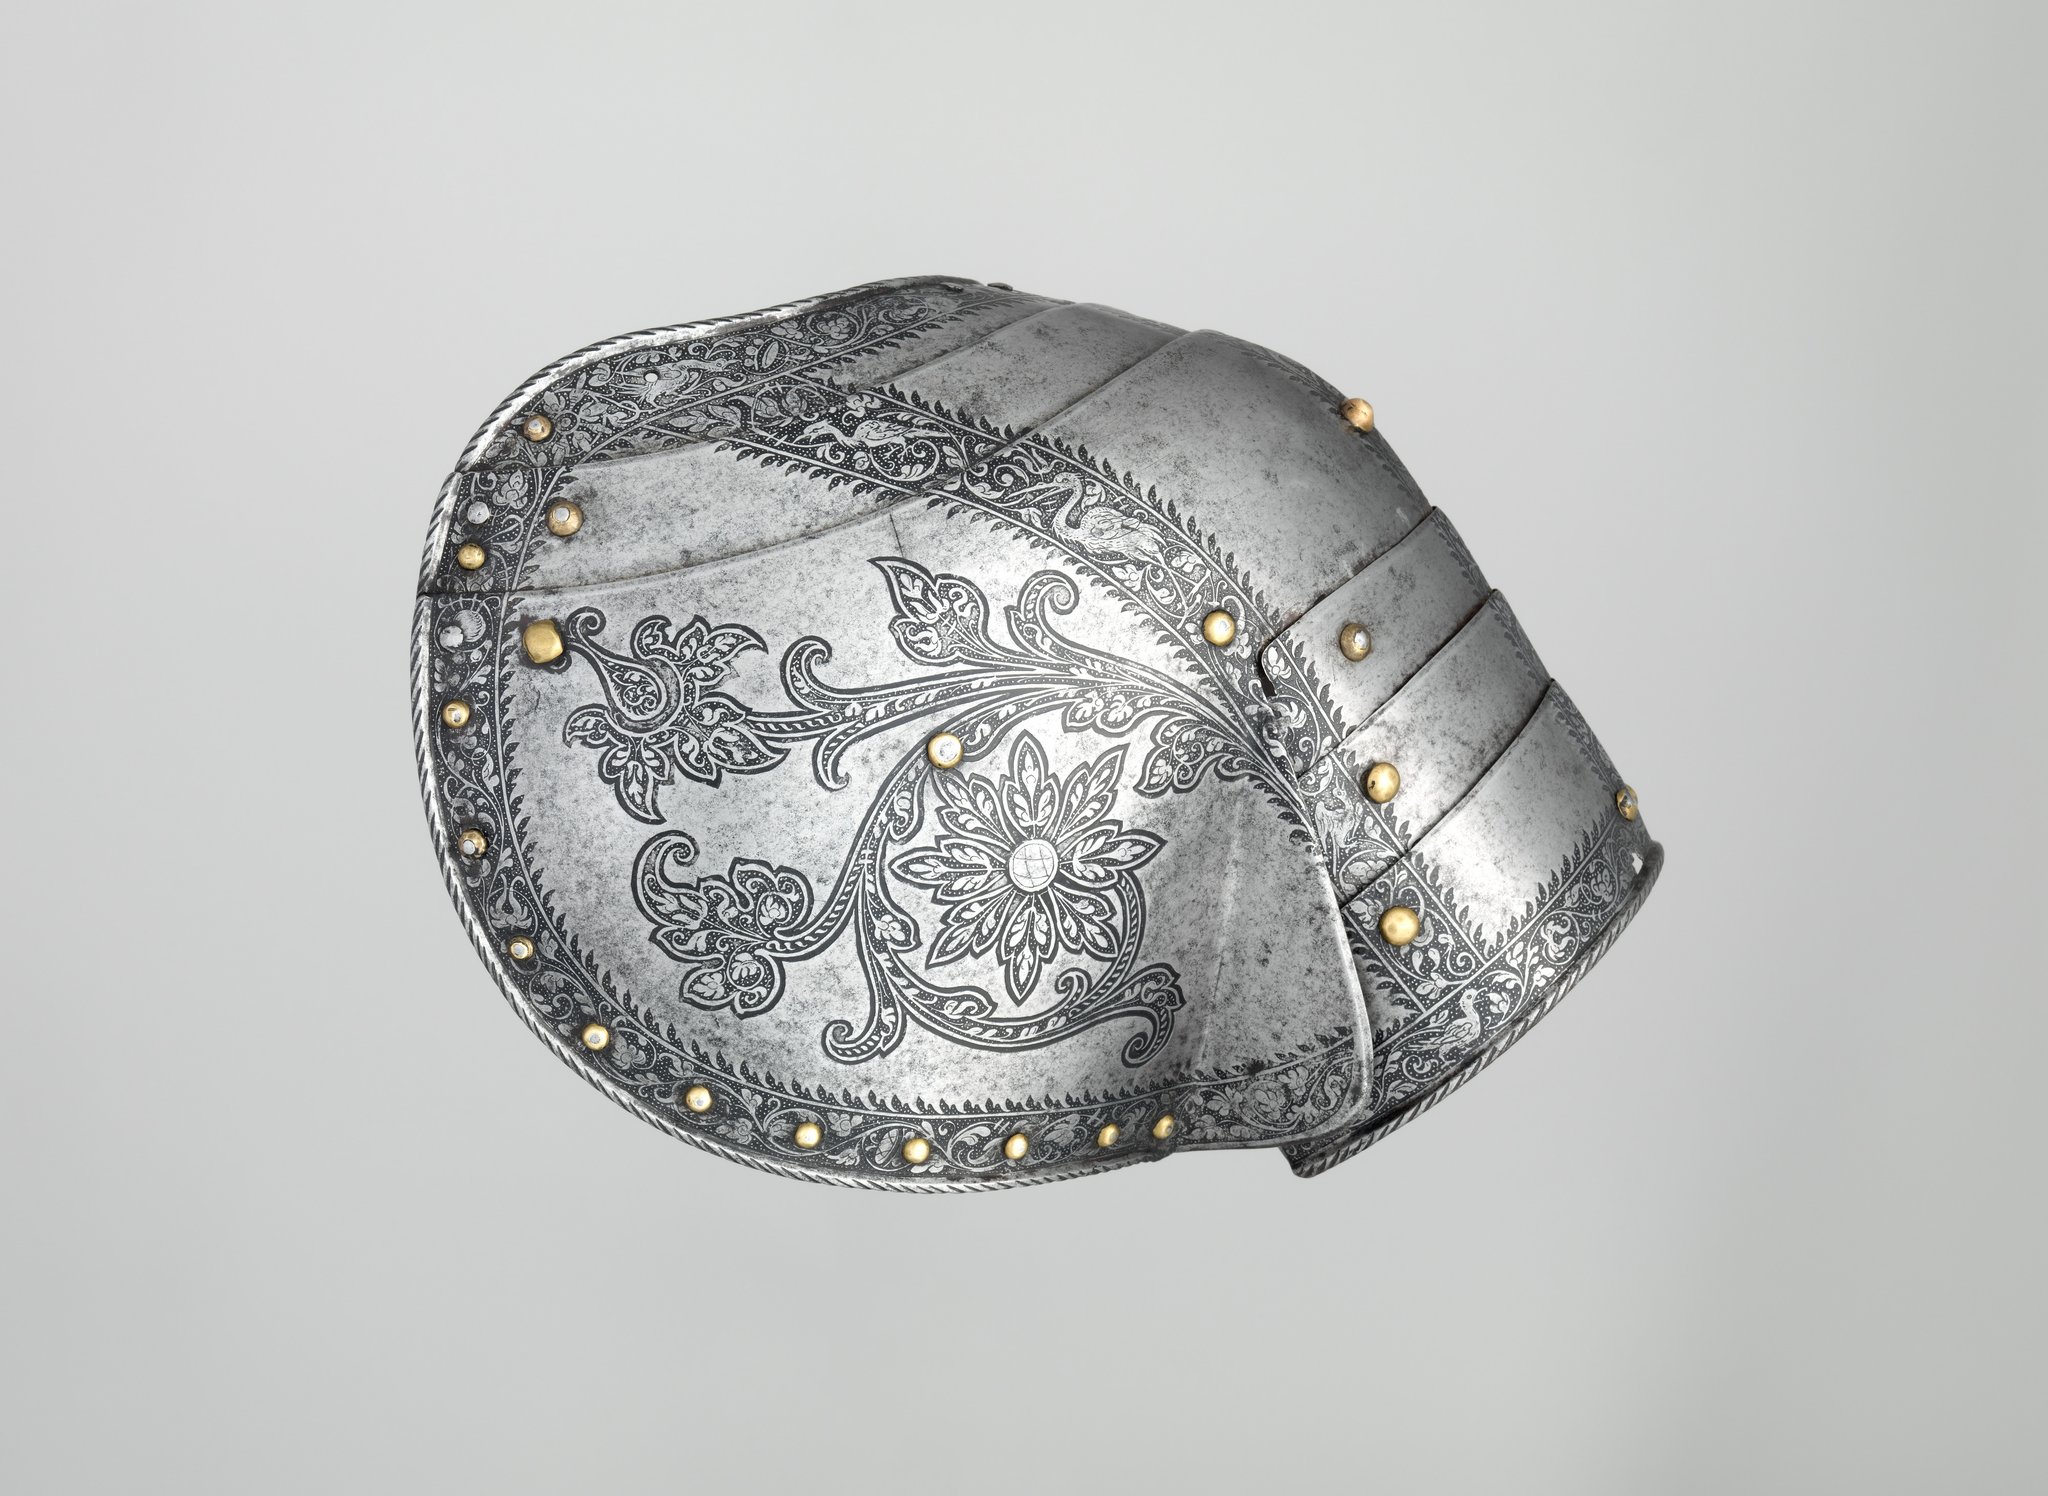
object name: right shoulder and arm defense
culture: german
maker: wolfgang grosschedel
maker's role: armorer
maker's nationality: german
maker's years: 1517-1562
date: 1555-1560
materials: copper alloy, leather, steel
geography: germany